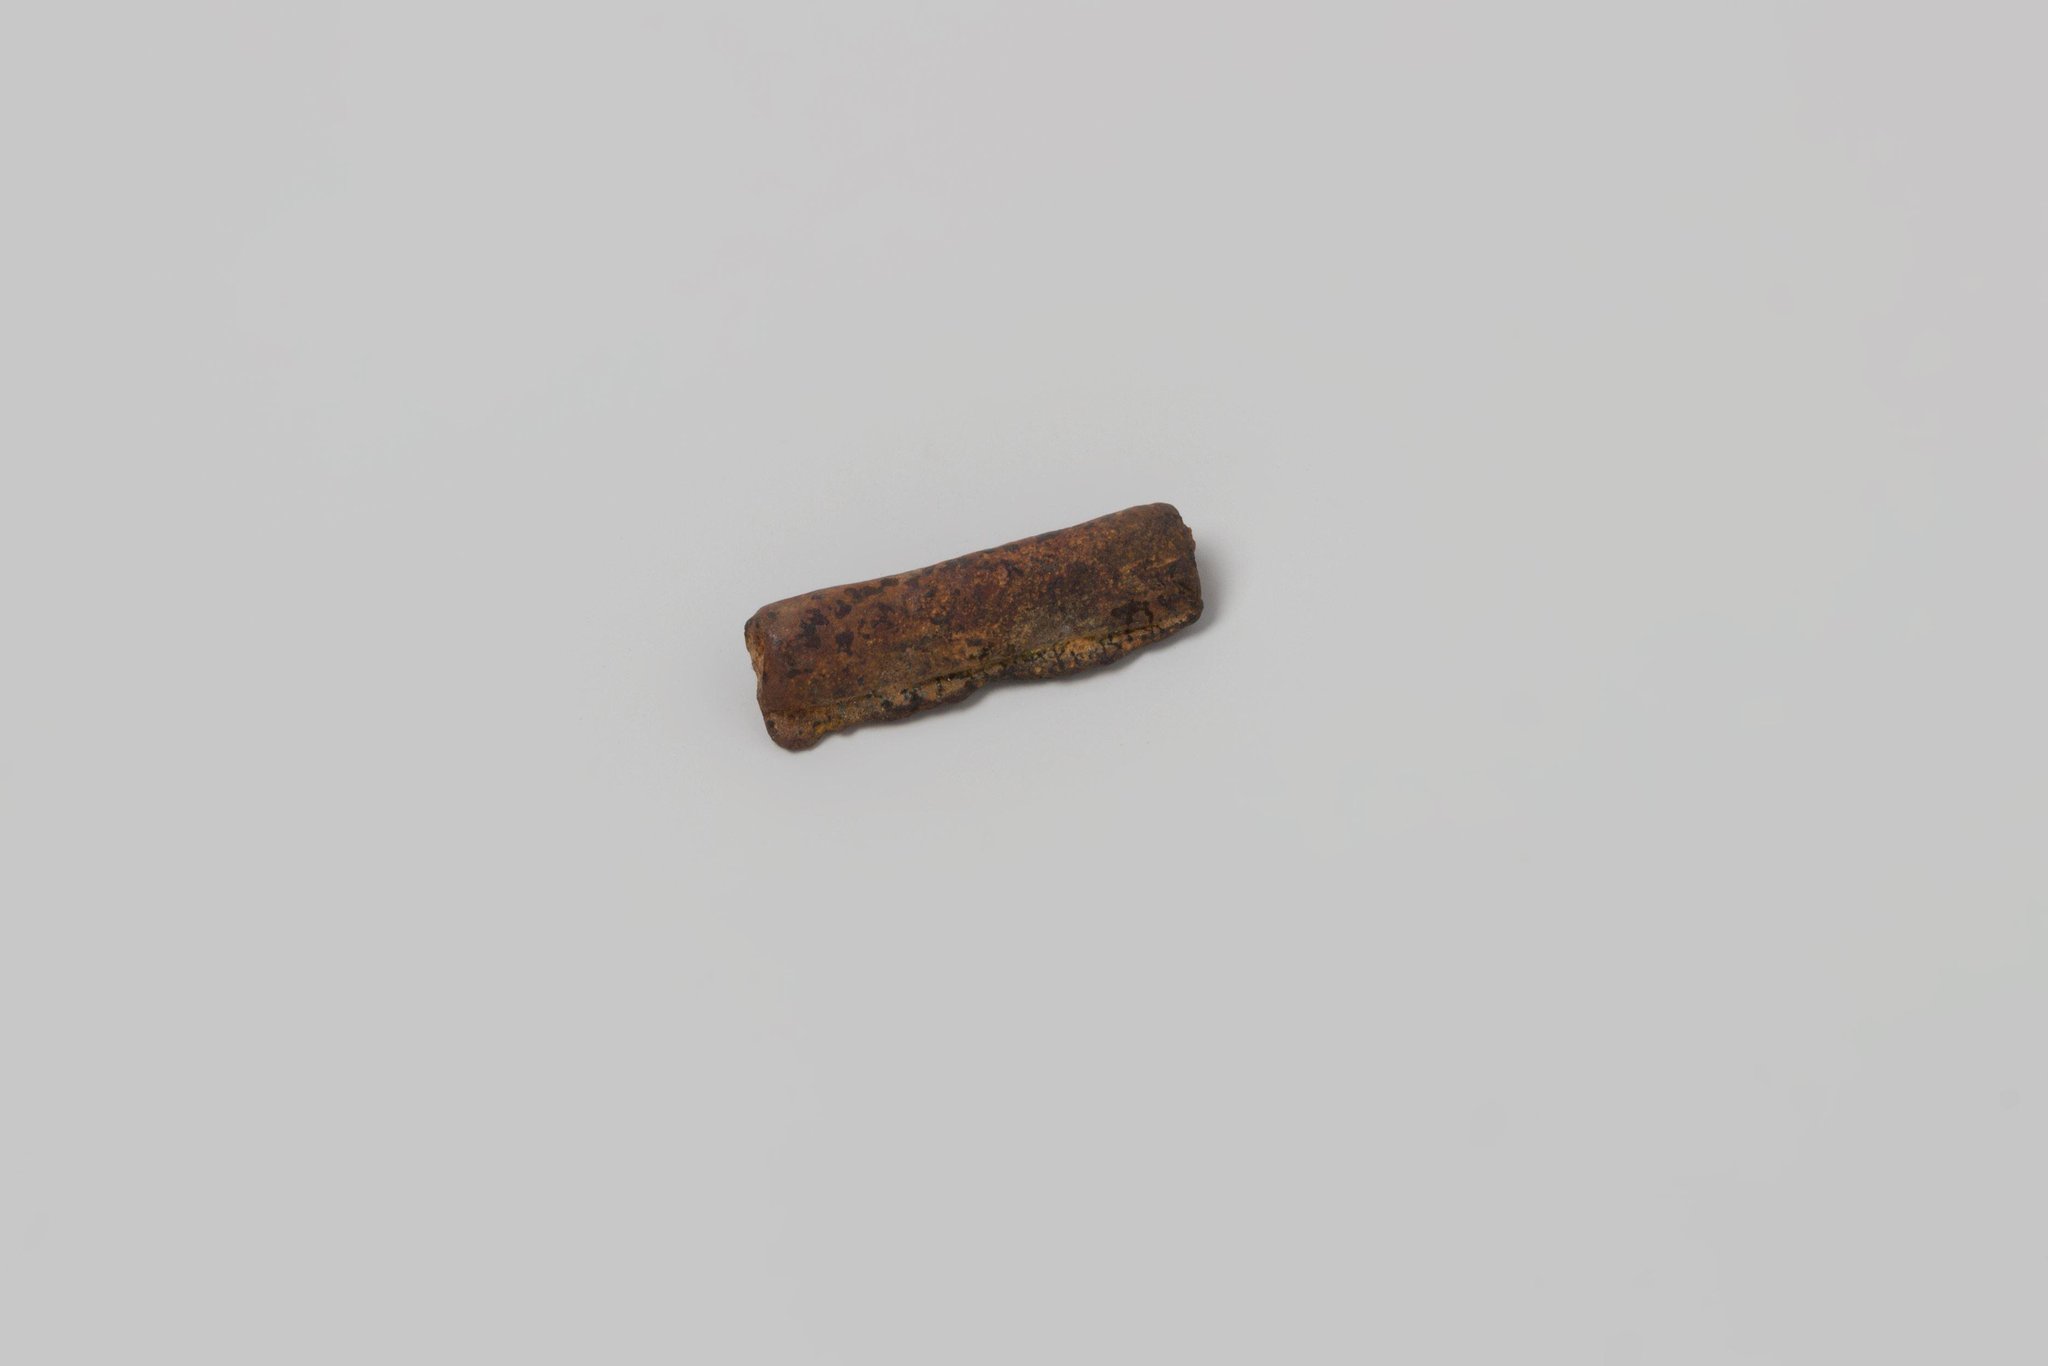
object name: fragment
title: Fragment koper uit het wrak van de Oost-Indiëvaarder Hollandia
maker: Anonymous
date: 1700-1743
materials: copper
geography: netherlands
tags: verenigde oostindische compagnie, hollandia (schip), annet